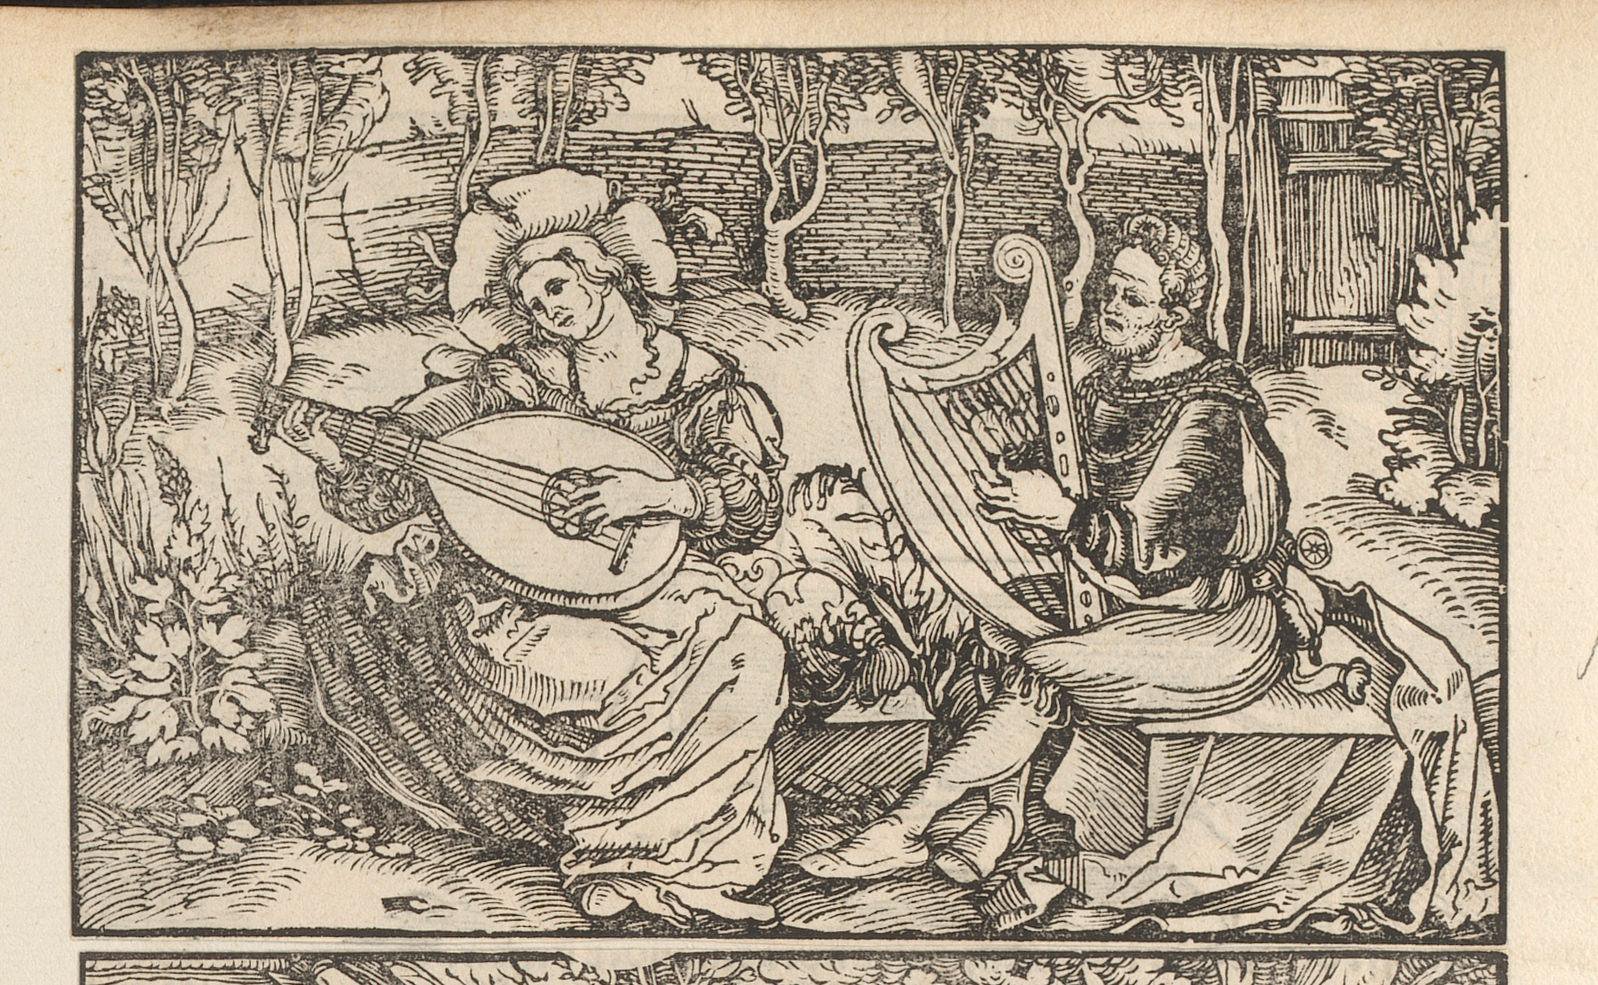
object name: album leaf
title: Musicerend duo in een tuin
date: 1514-1531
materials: paper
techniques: letterpress printing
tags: more than one musician with instrument - cc - 'concert champêtre', harp, lute, and special forms of lute, e.g.: theorbo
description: Deze prent is gebruikt in: Petrarca, Francesco. Von der Artzney bayder Glück, des guten und widerwertigen: unnd weß sich ain yeder inn Gelück und Unglück halten sol (...). Augsburg: Heinrich Steiner, 1532. Deze uitgave is ook bekend onder de titel 'Trostspiegel in Glück und Unglück'. Deze prent is ook gebruikt in: Cicero, Marcus Tulius. Officia M.T.C. Ein Buch so Marcus Tullius Cicero der Römer zu seynem (...). [Vertaald uit het Latijn door] Johann von Schwarzenberg. Augsburg: Heinrich Steiner, 1531.